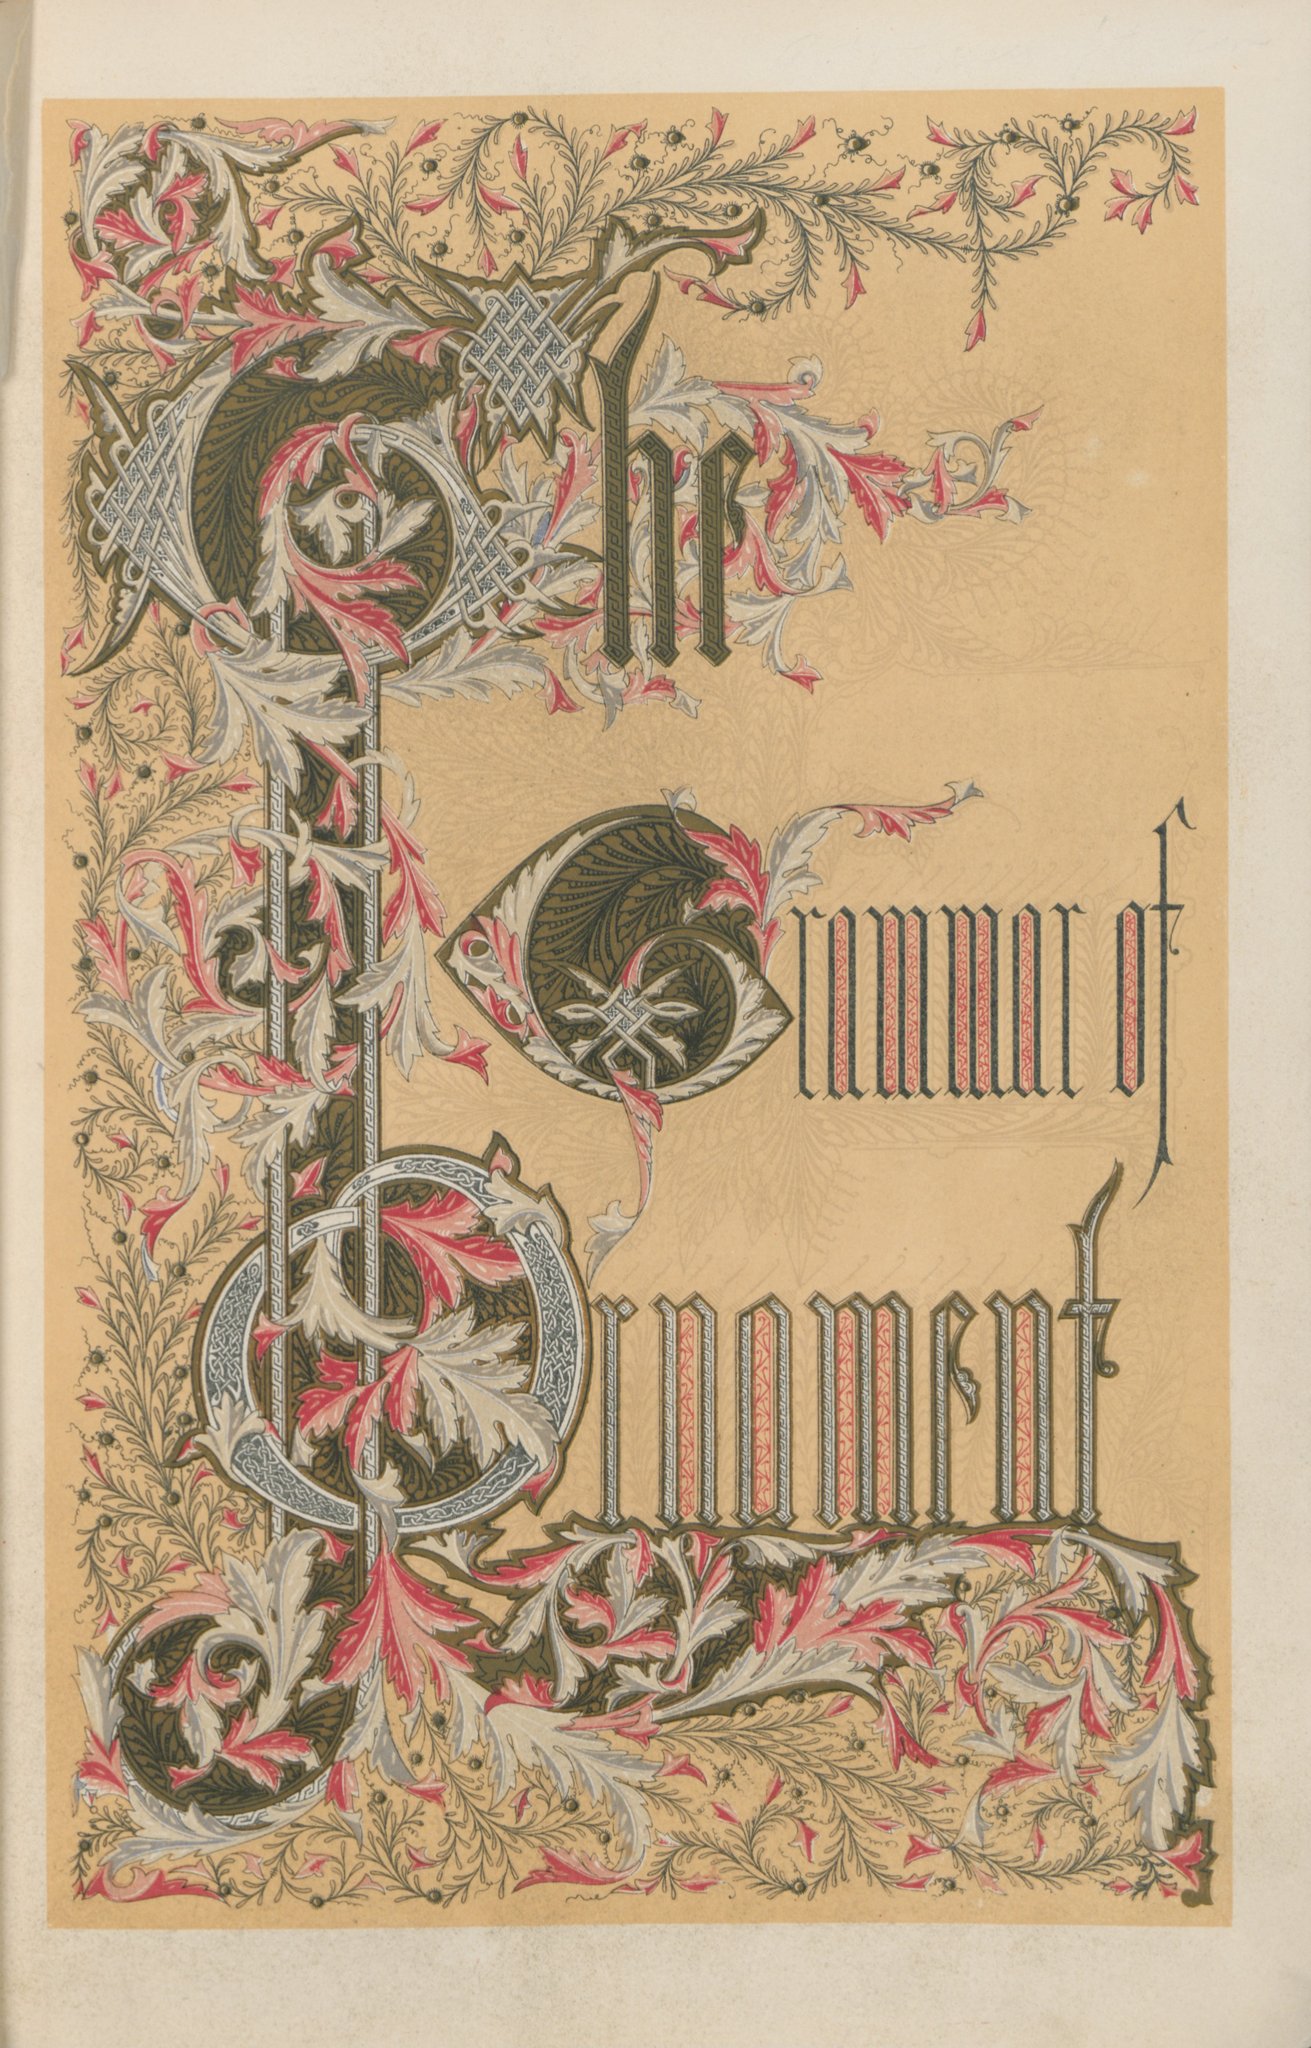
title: The grammar of ornament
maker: owen jones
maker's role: author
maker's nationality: british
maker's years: 1809-1874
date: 1868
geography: london